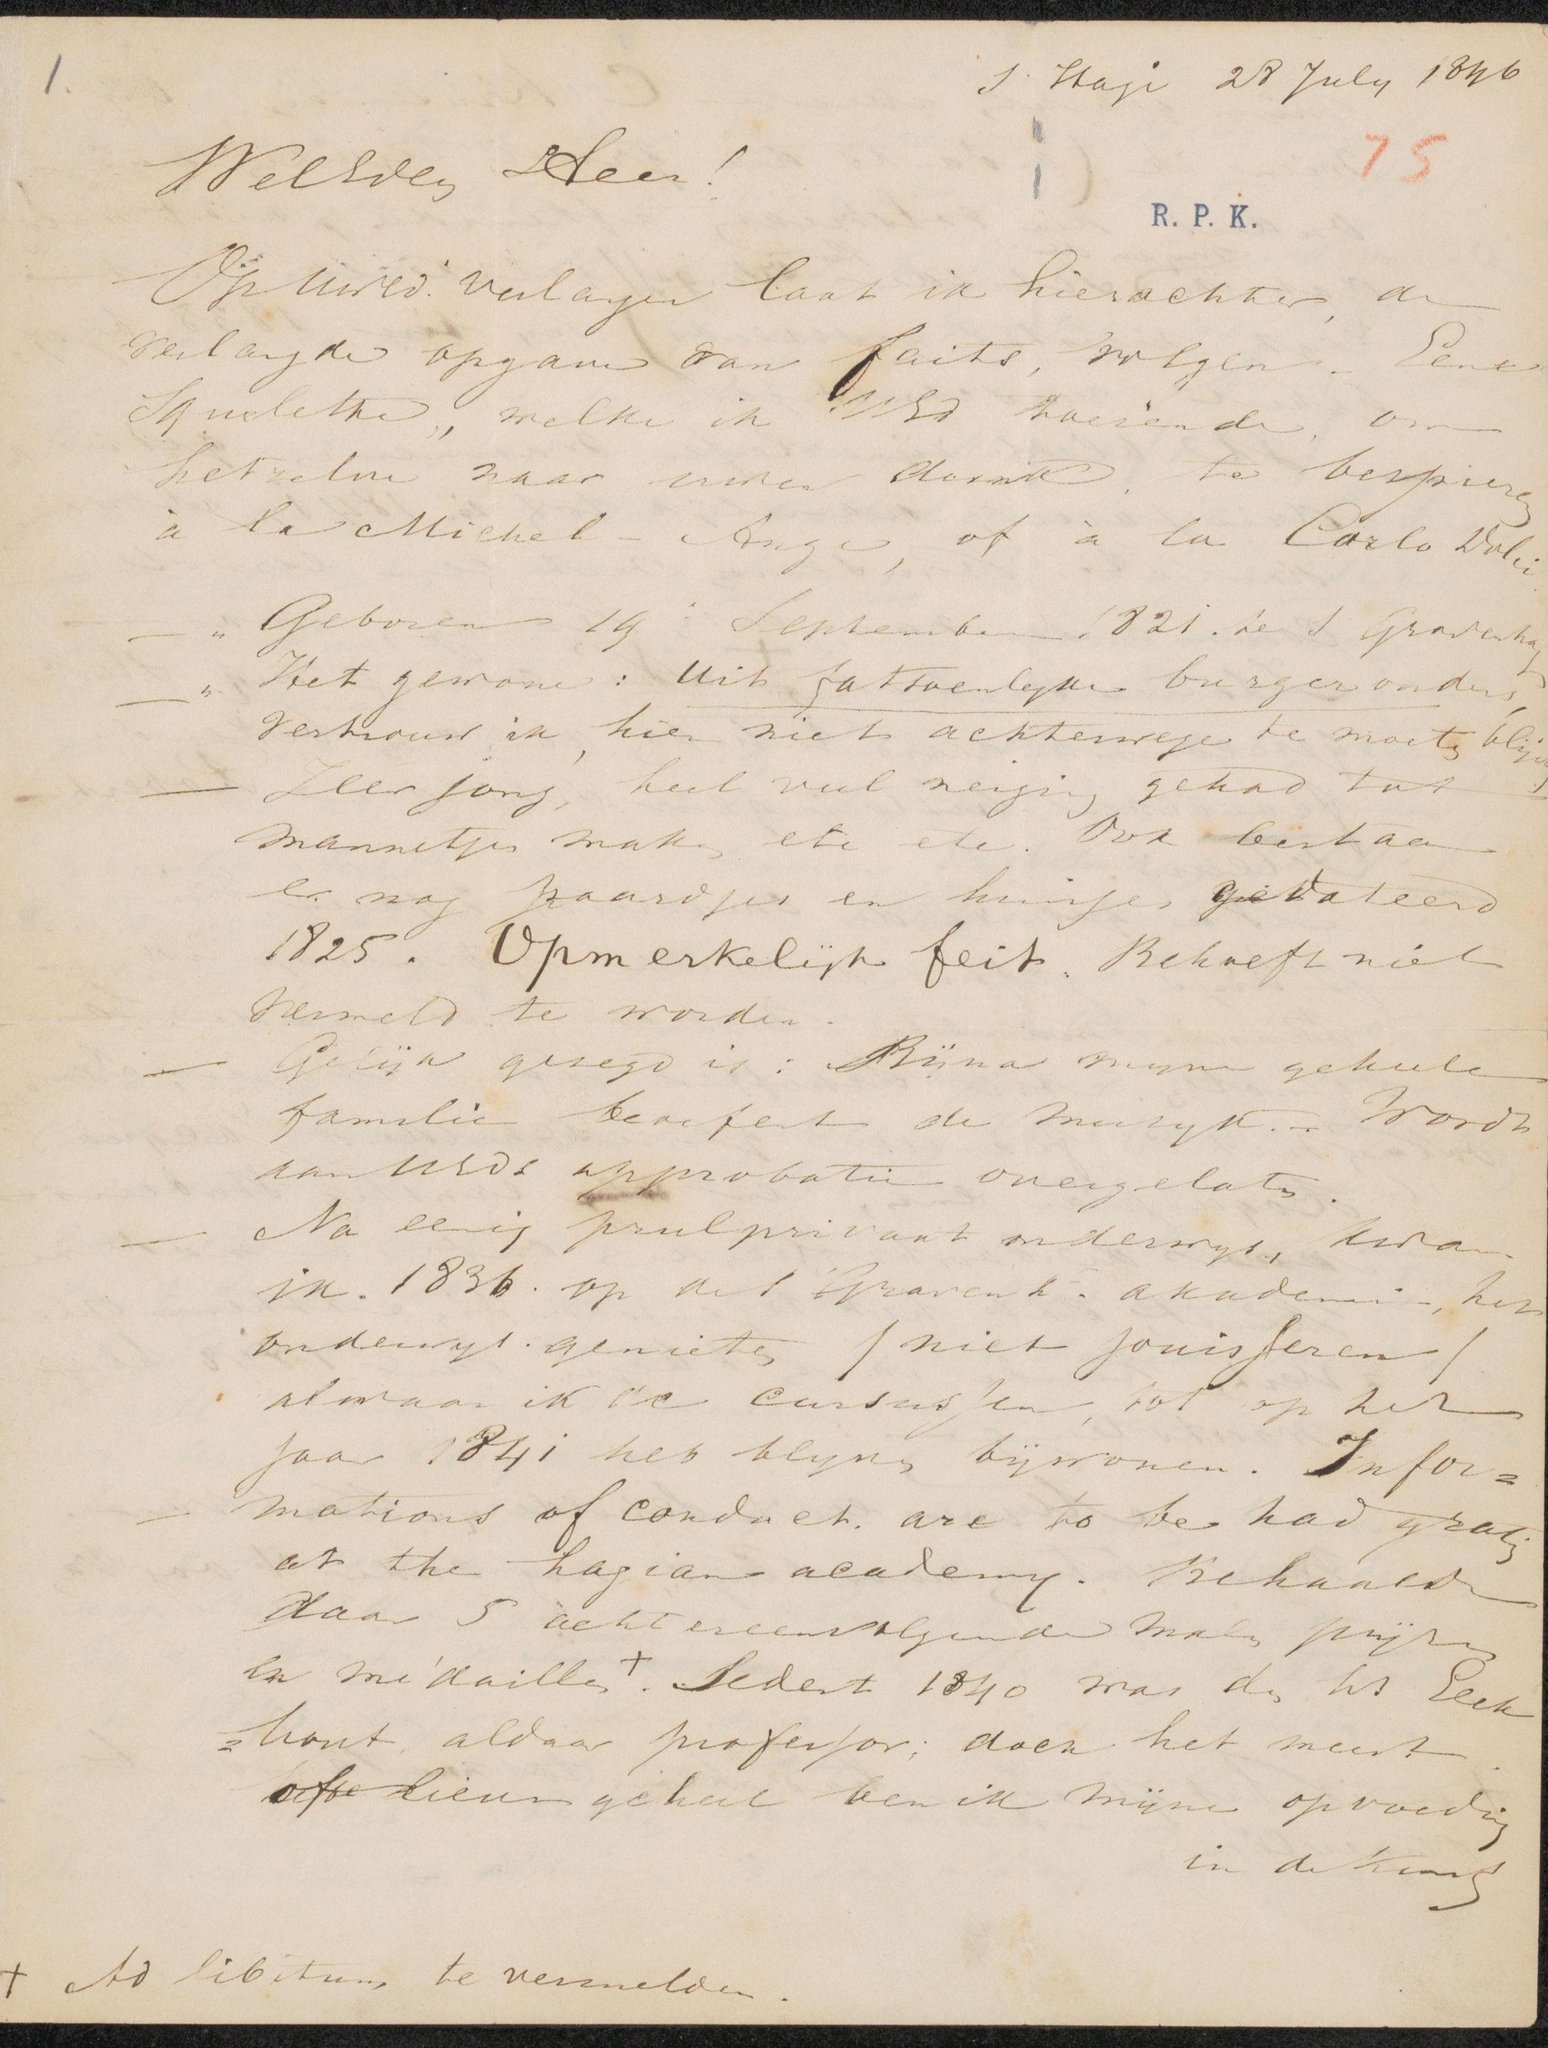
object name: letter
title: Brief aan Johannes Jacobus Franciscus Wap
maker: david bles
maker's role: draughtsman, painter, print maker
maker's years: 1821-1899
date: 1846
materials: ink, paper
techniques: pen, writing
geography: the hague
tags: utrecht, painter, print maker, draughtsman, louis meijer, dordrecht, ary scheffer, cornelis kruseman, jacob cats (1577-1660), johannes jacobus franciscus wap, distribution of awards ~ art contest, education, tuition of the artist (in general), painting (including book-illumination, miniature-painting), exhibition ~ art, the hague, rotterdam, brussels, paris, amsterdam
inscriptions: collector's mark: Lugt 2233